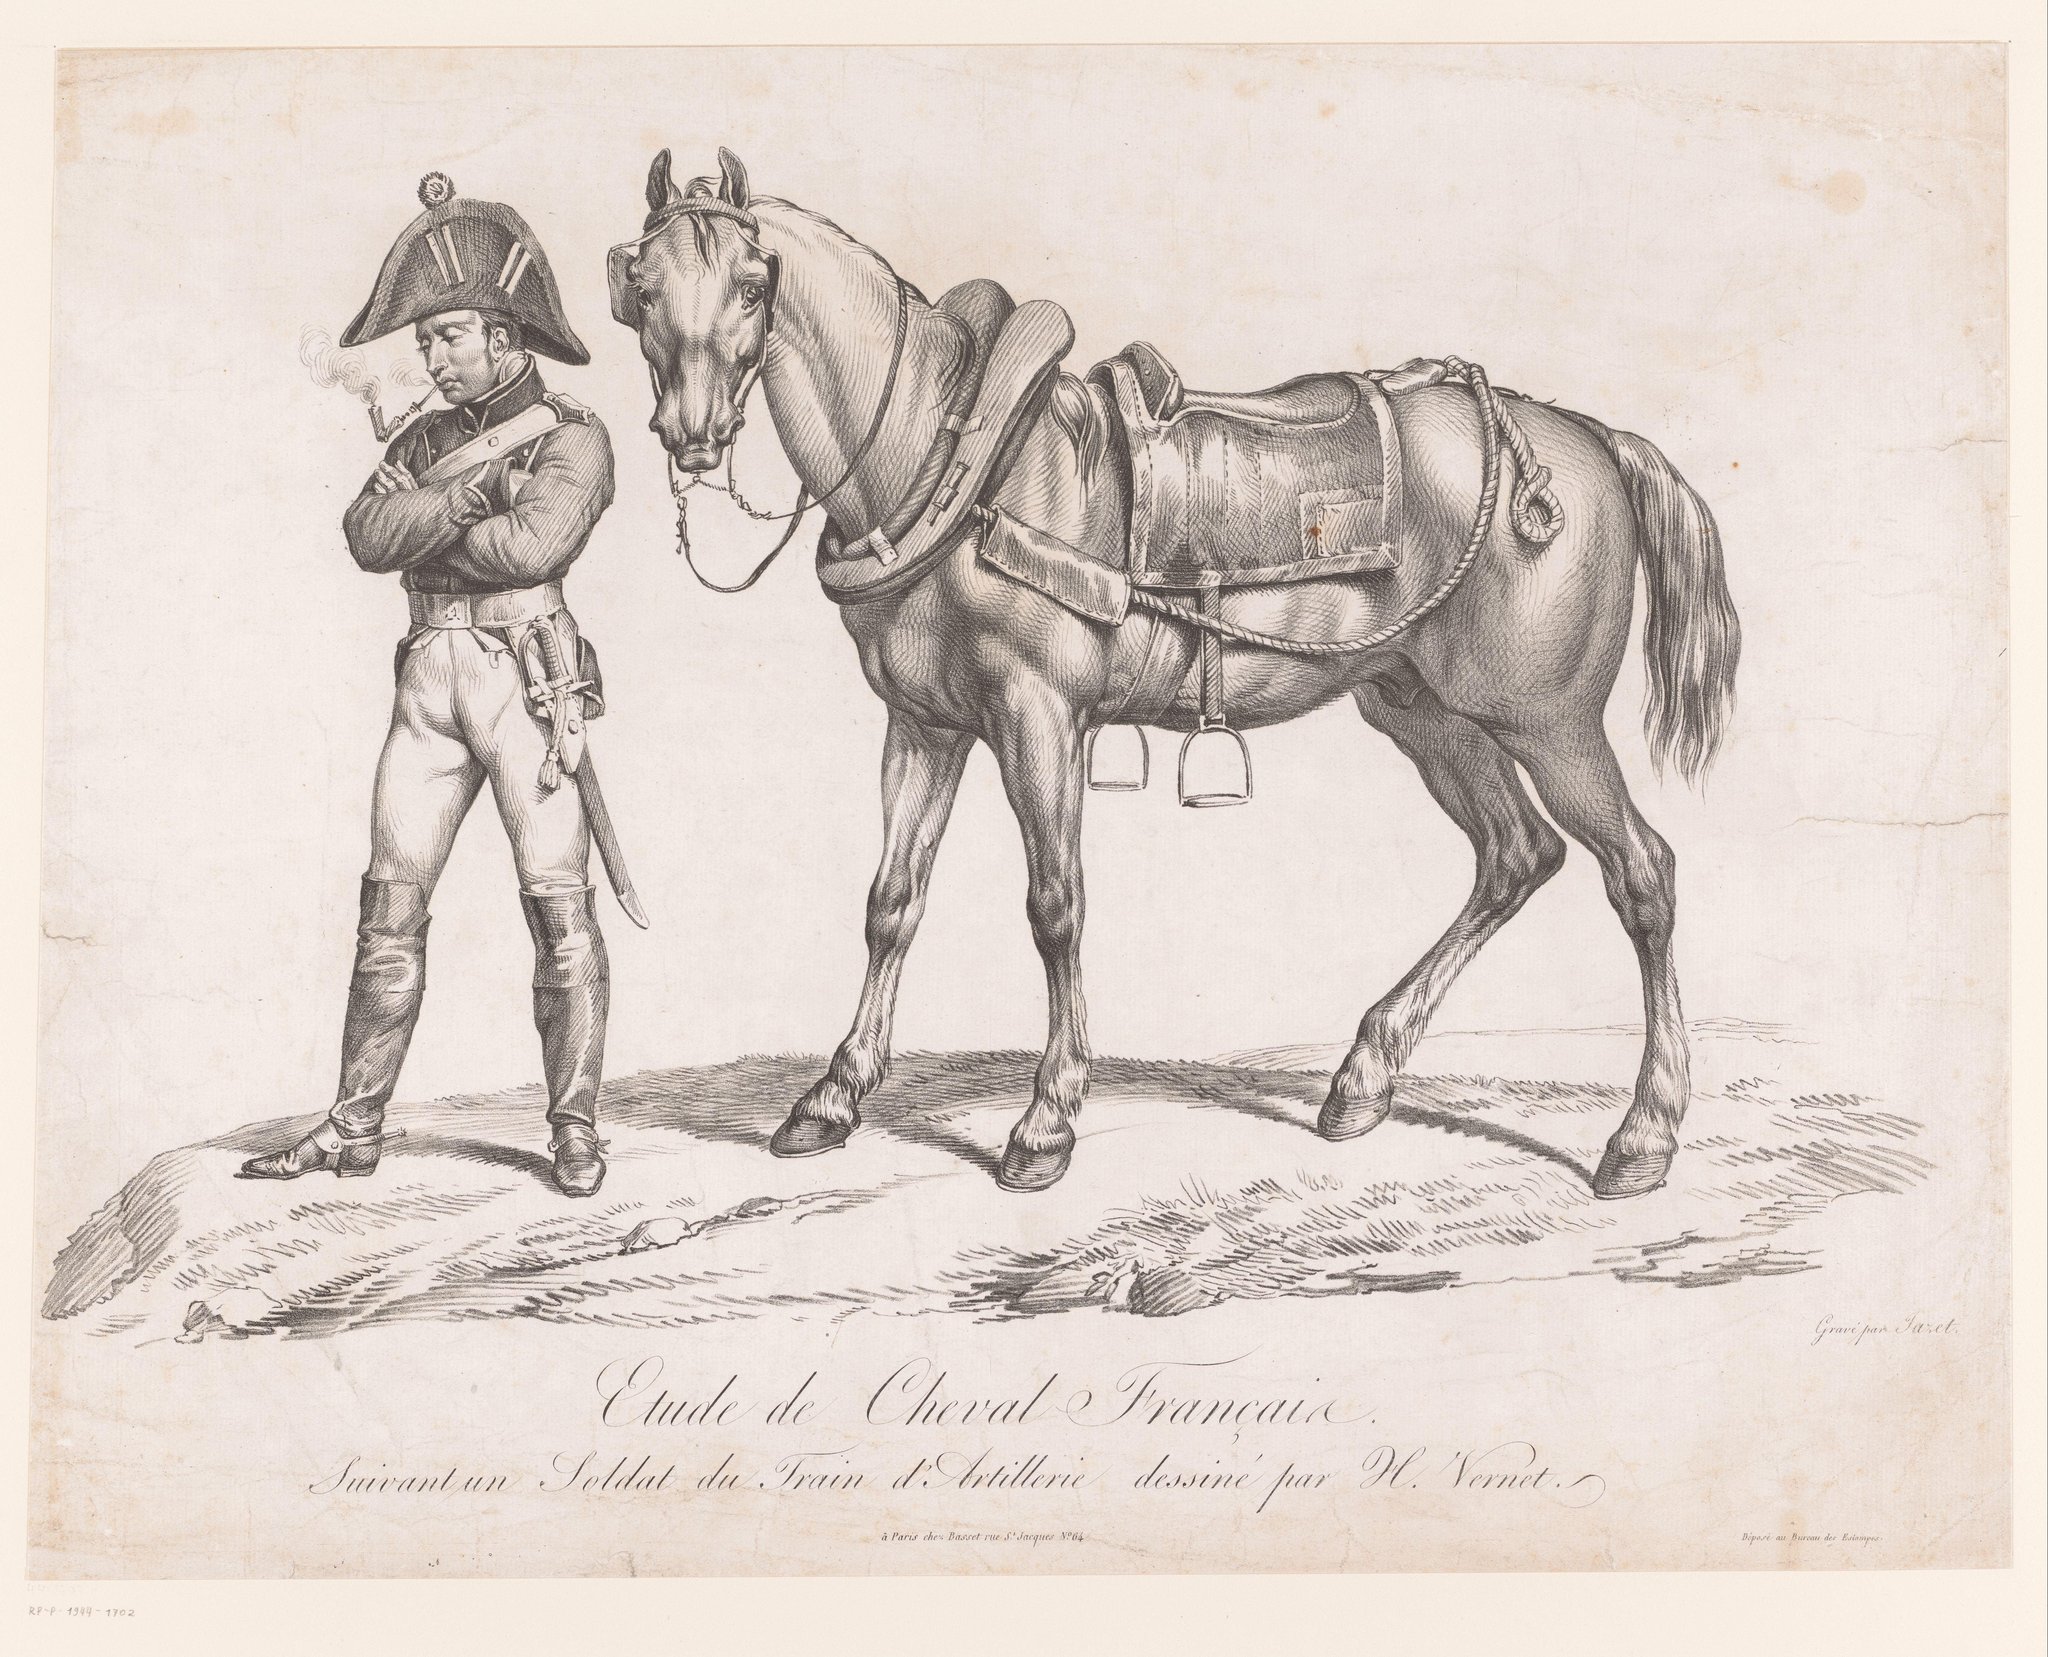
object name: print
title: Soldaat met zijn paard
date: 1799-1871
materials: paper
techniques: printmaking, engraving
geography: paris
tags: private soldier, pipe ~ tobacco, horse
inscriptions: : ‘Déposé au Bureau des Estampes’, collector's mark: Lugt 2228